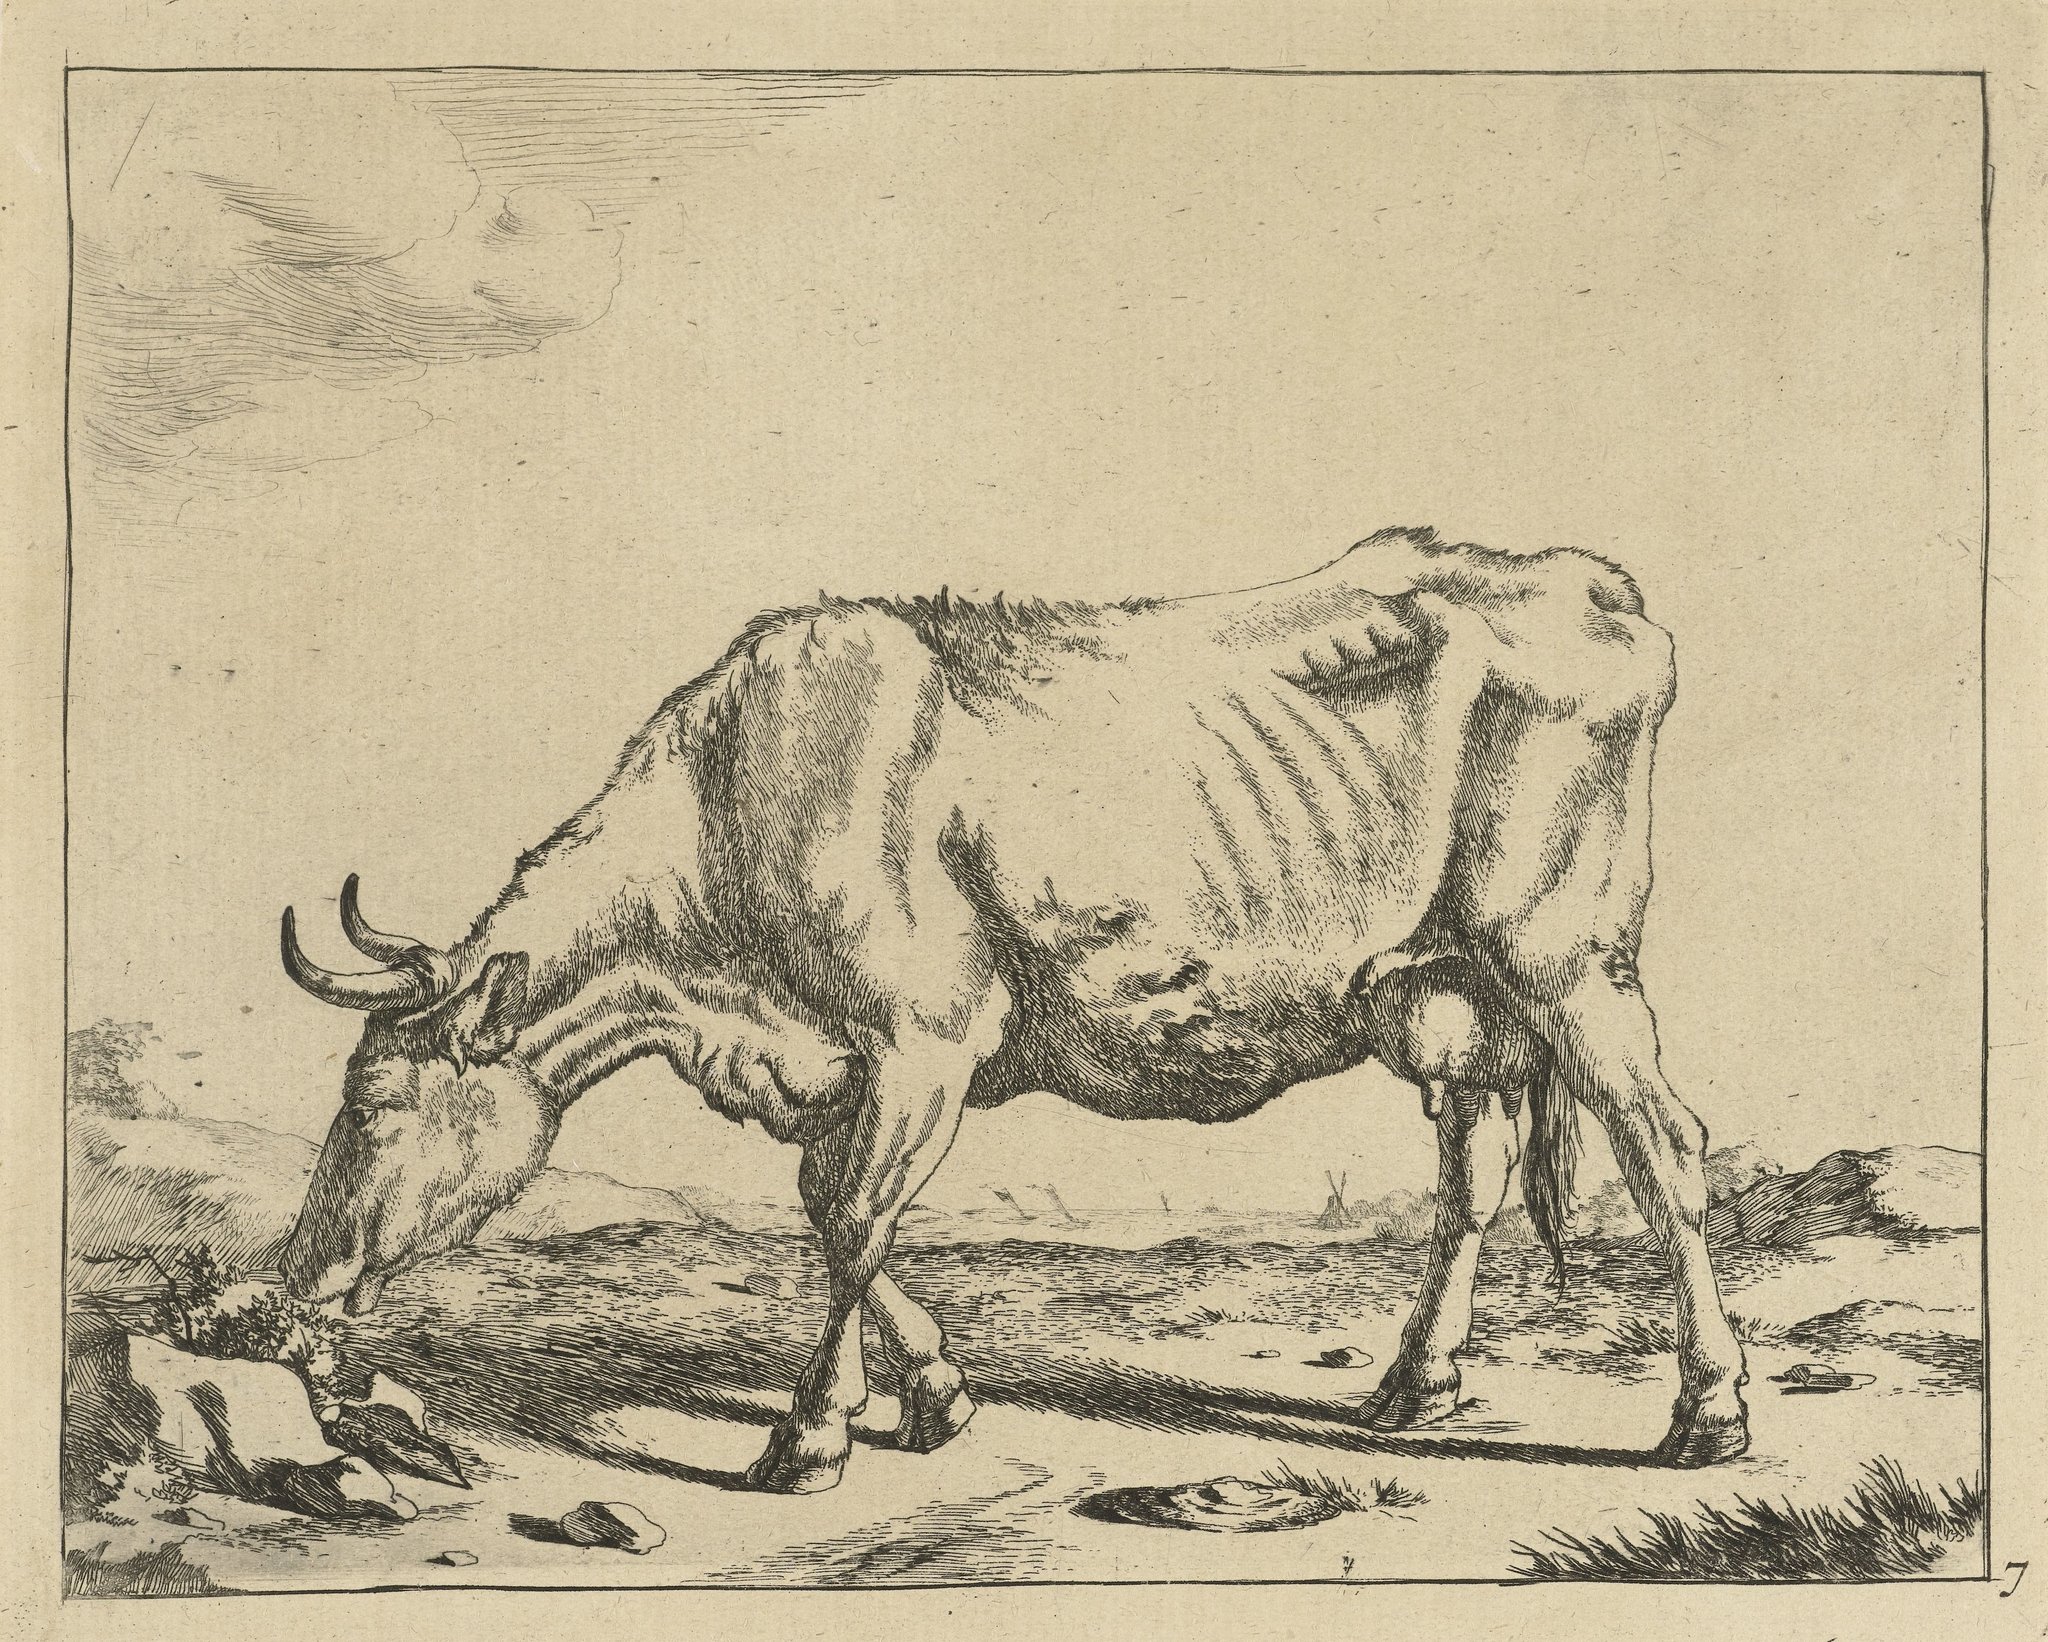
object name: print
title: Runderen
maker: marcus de bye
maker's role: print maker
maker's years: 1639-1688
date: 1657-1677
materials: paper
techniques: etching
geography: the hague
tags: cow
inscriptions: collector's mark: Lugt 2228